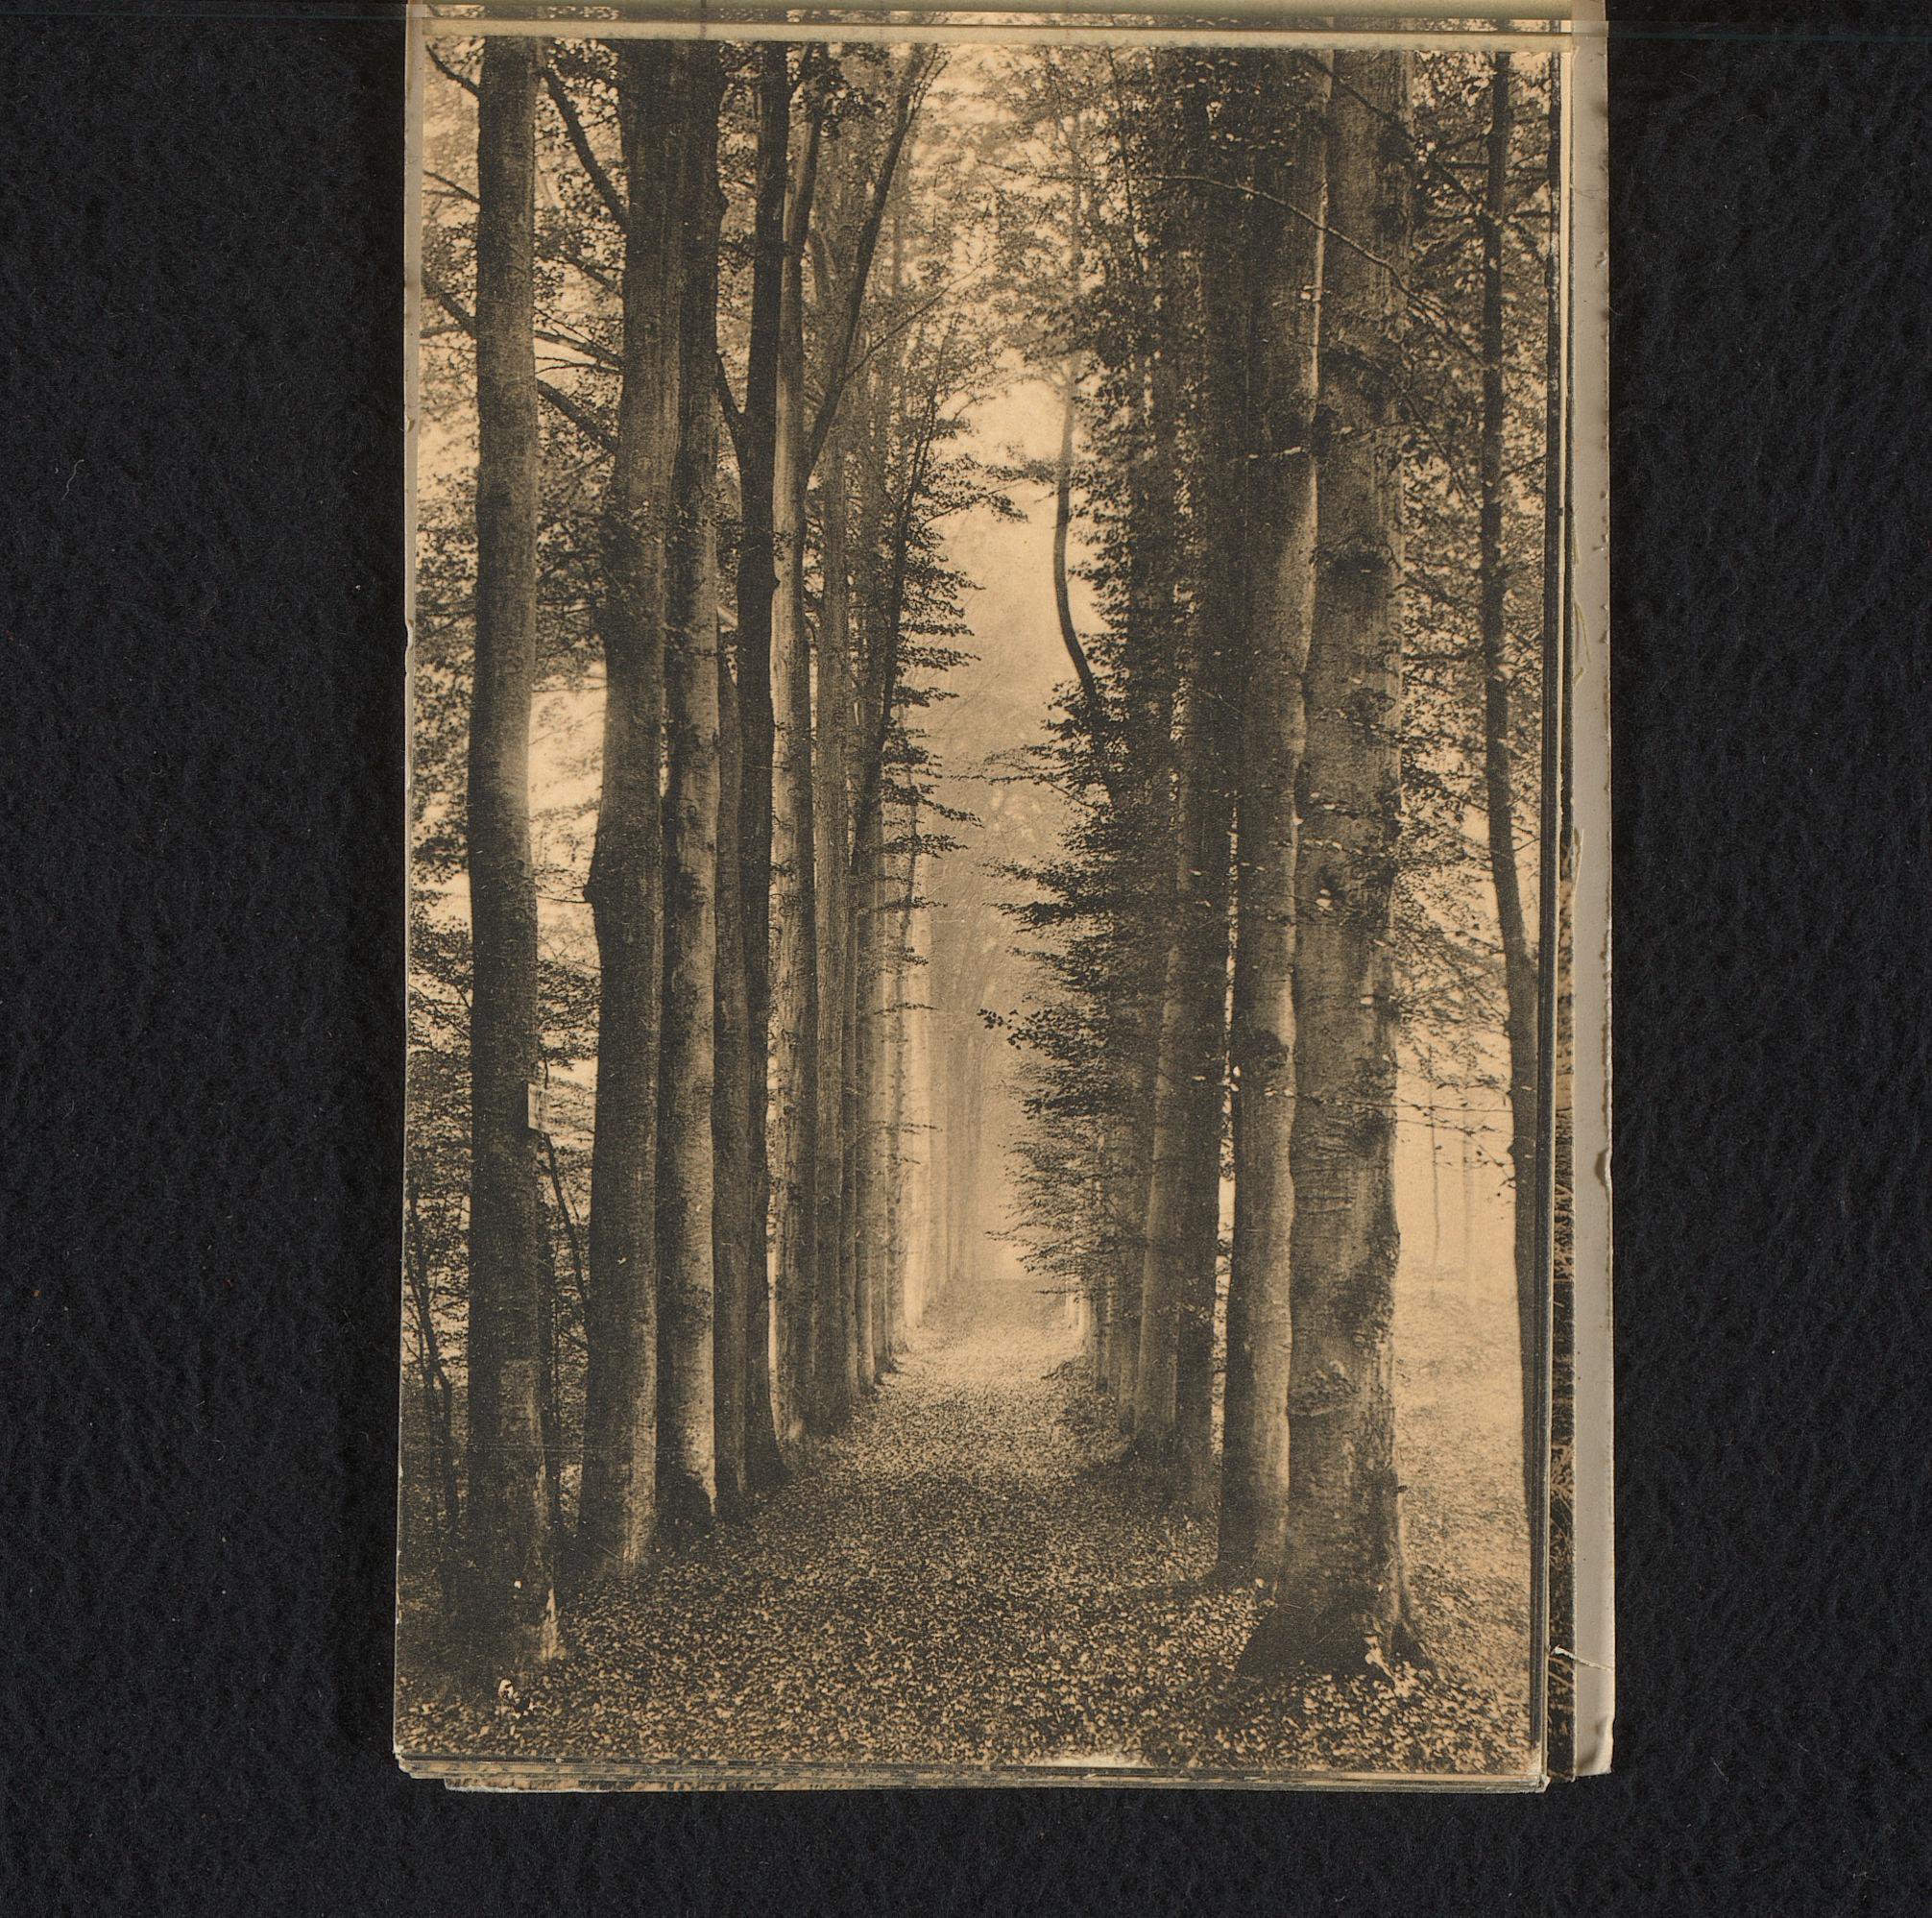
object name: photomechanical print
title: Drève des Enfants noyés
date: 1909-1914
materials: cardboard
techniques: photograph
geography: etterbeek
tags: forest path or lane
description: Prentbriefkaart maakt deel uit van een album.